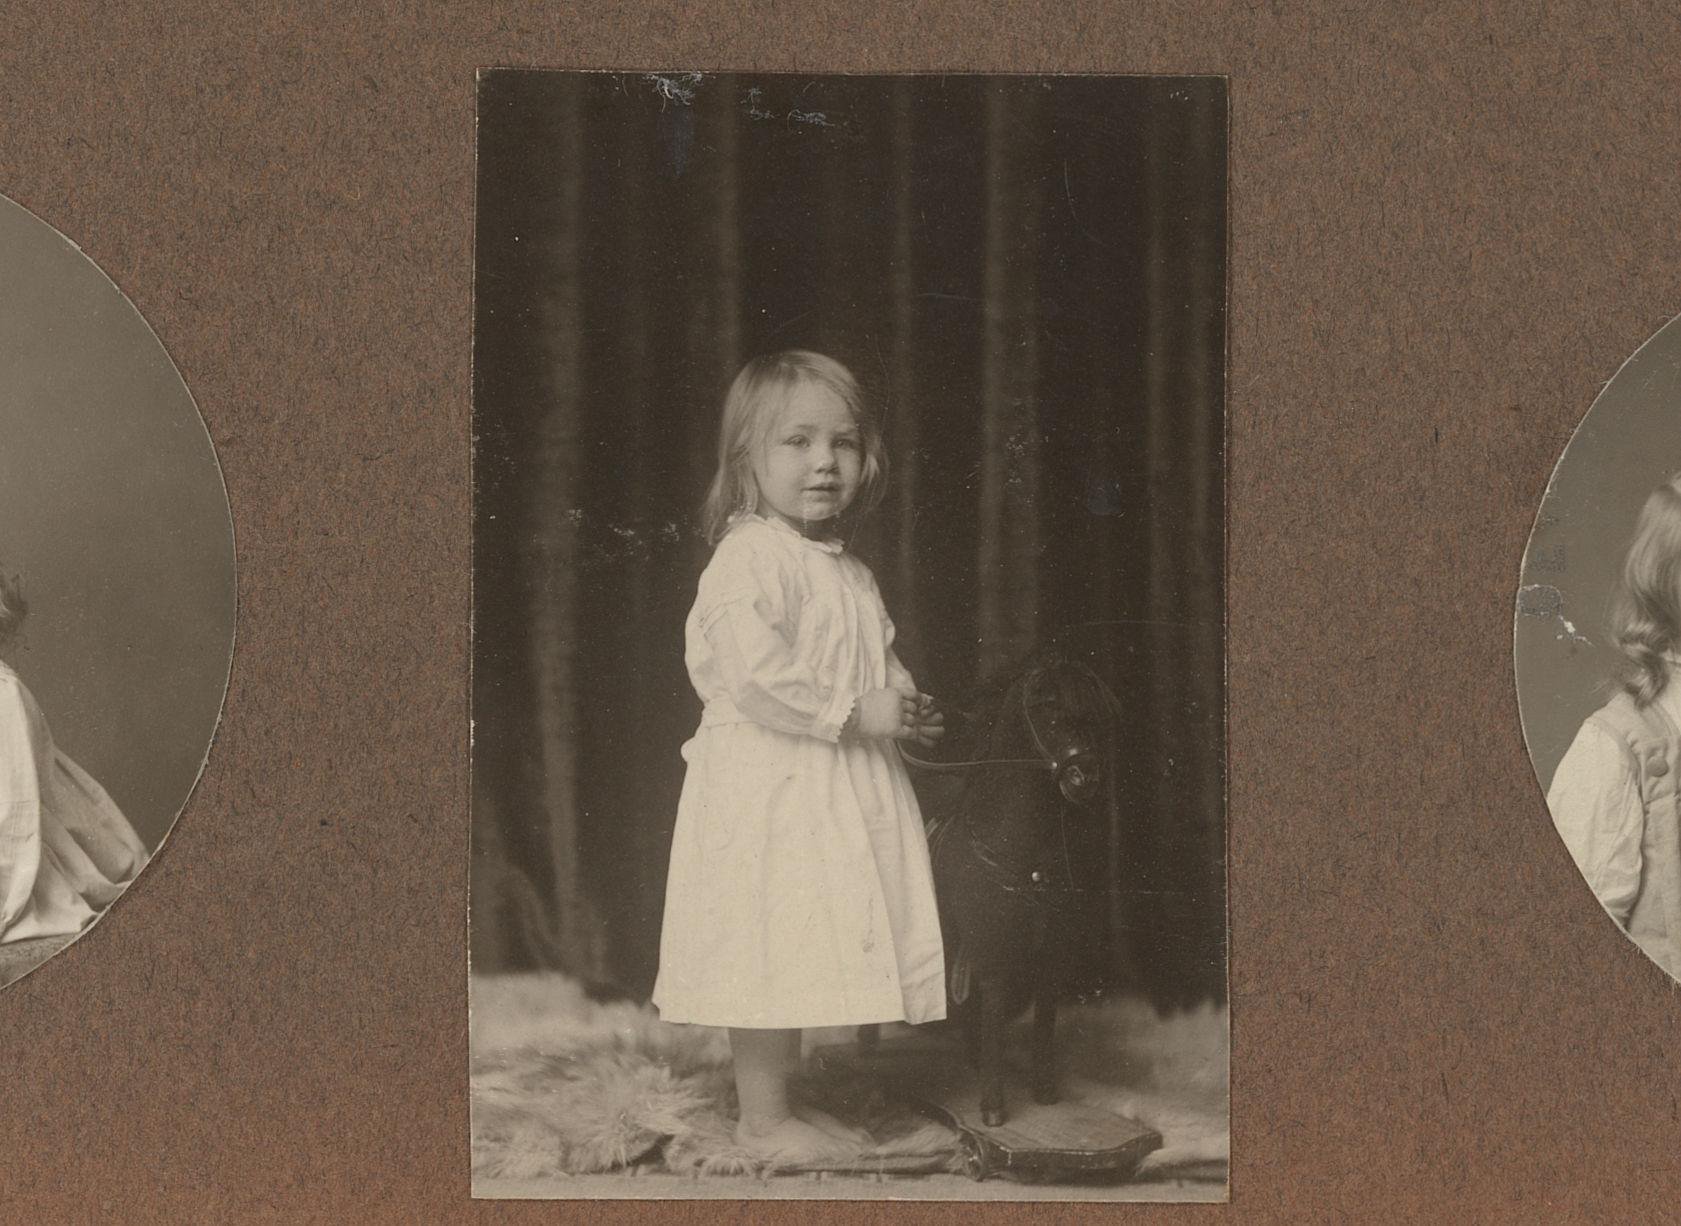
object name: photograph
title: Dochter van Diepenbrock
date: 1870-1920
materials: photographic support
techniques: photography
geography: amsterdam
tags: netherlands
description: Foto op bruin albumblad 44 van familiealbum van Alphons Diepenbrock.